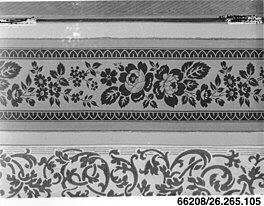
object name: border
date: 1801-1833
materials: cotton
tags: roses